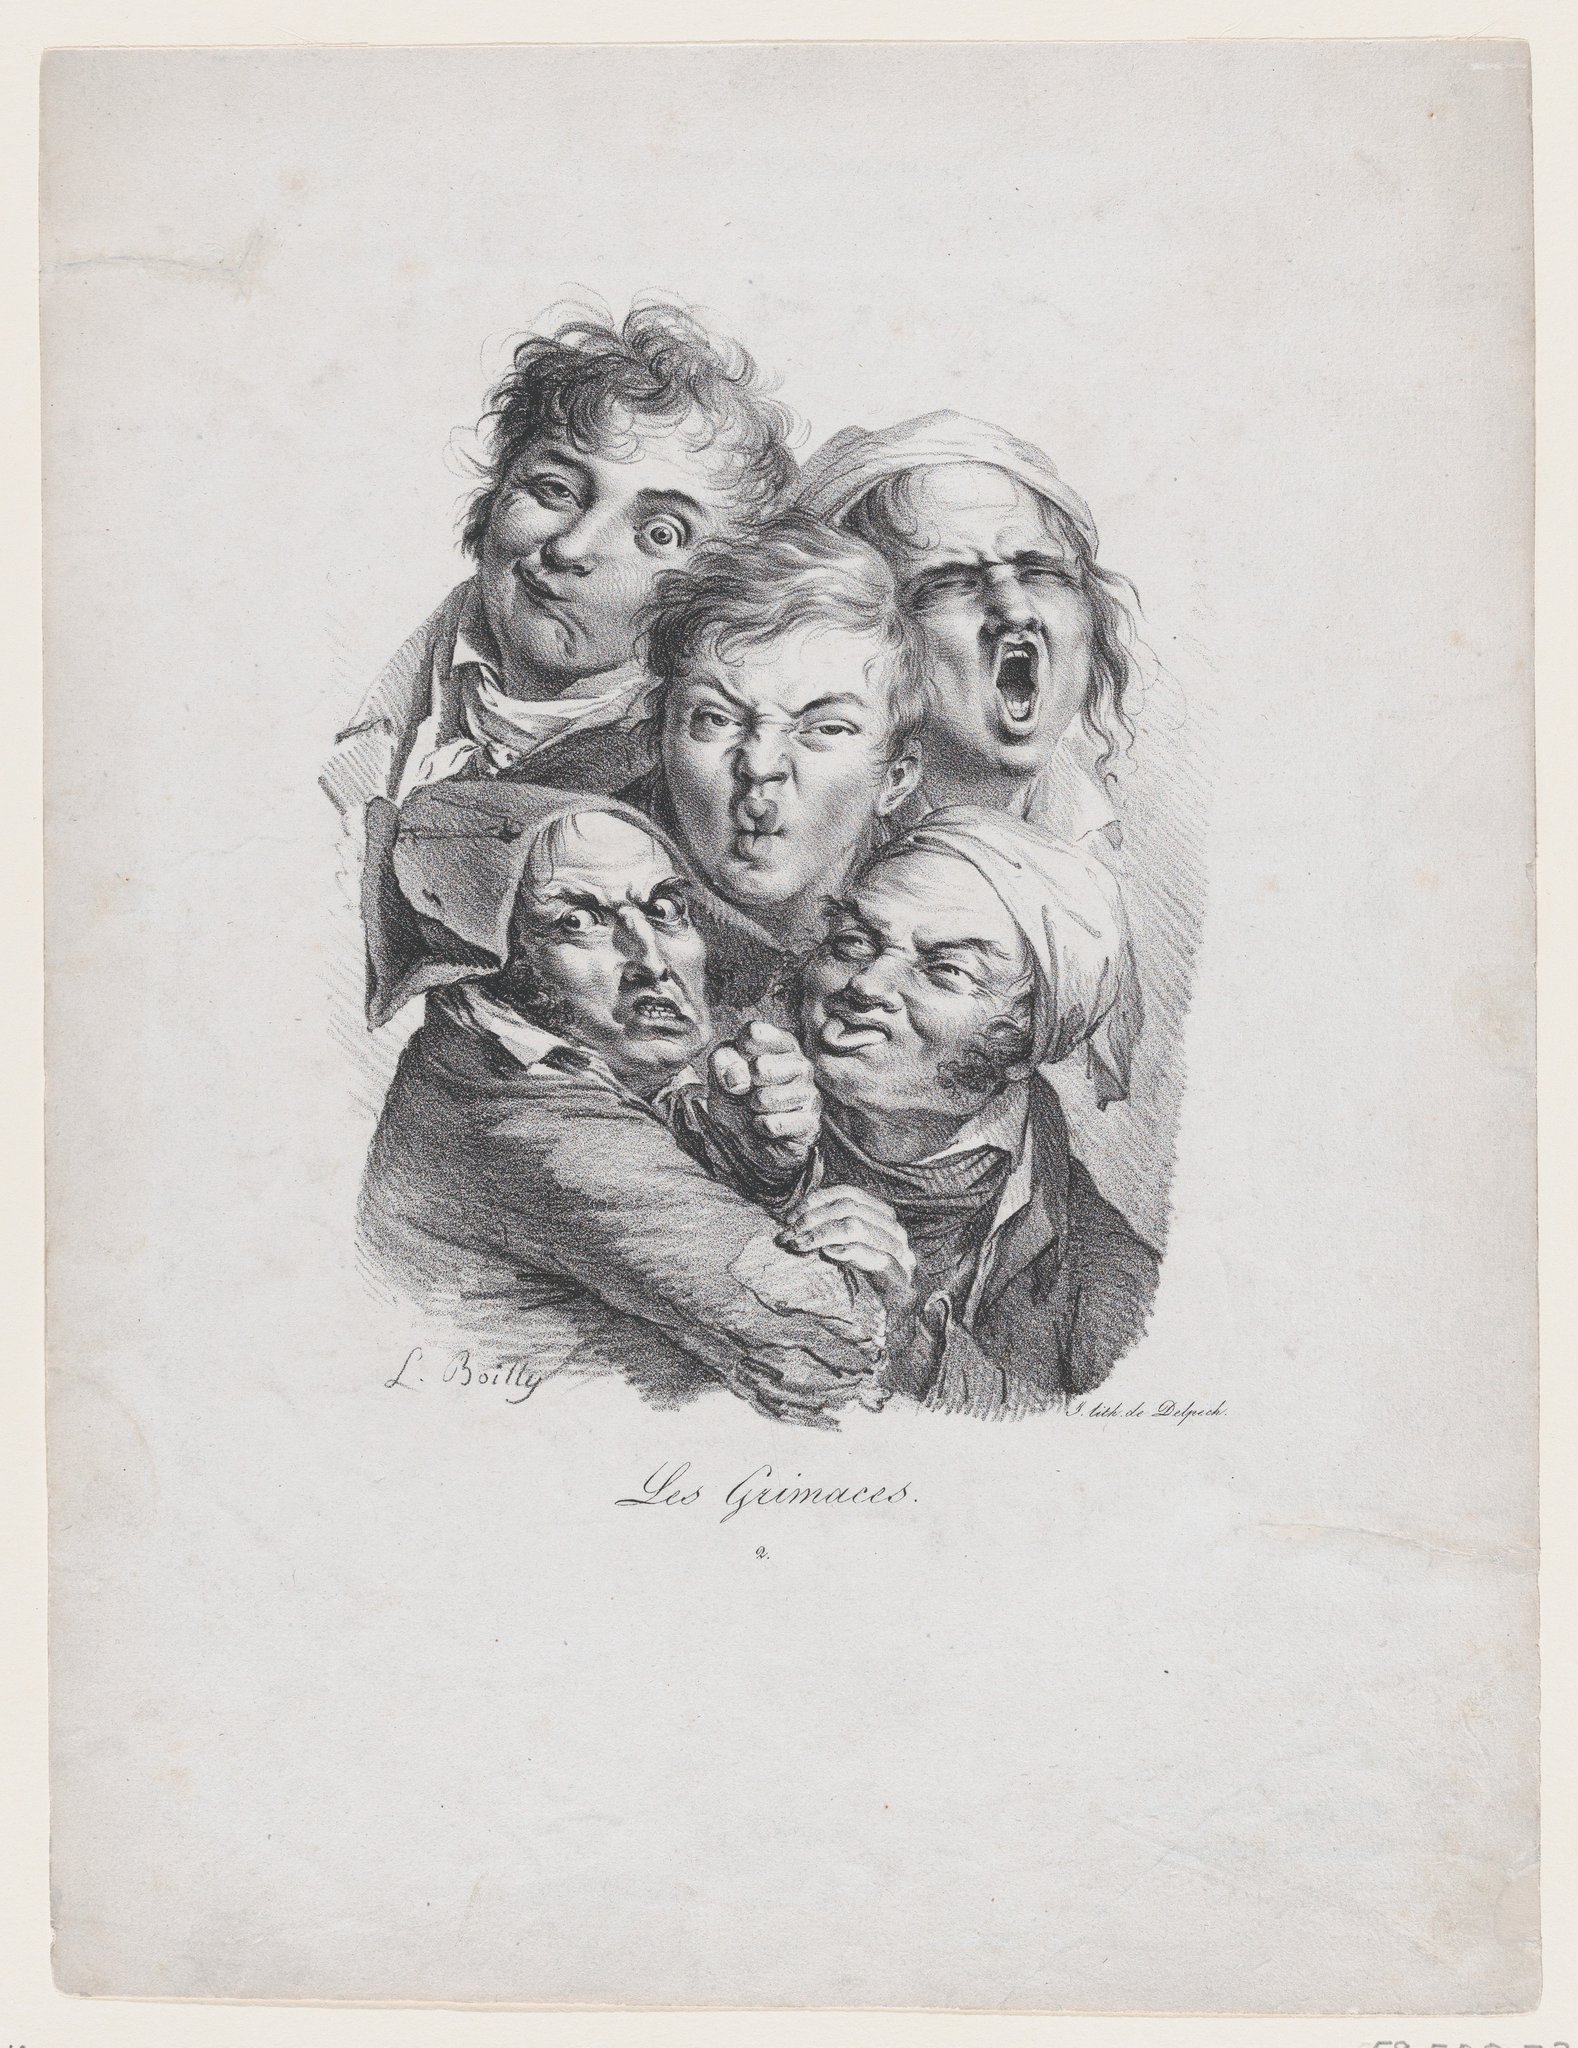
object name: print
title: The Grimaces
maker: louis léopold boilly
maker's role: artist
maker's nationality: french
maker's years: 1761-1845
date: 1823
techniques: lithograph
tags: men